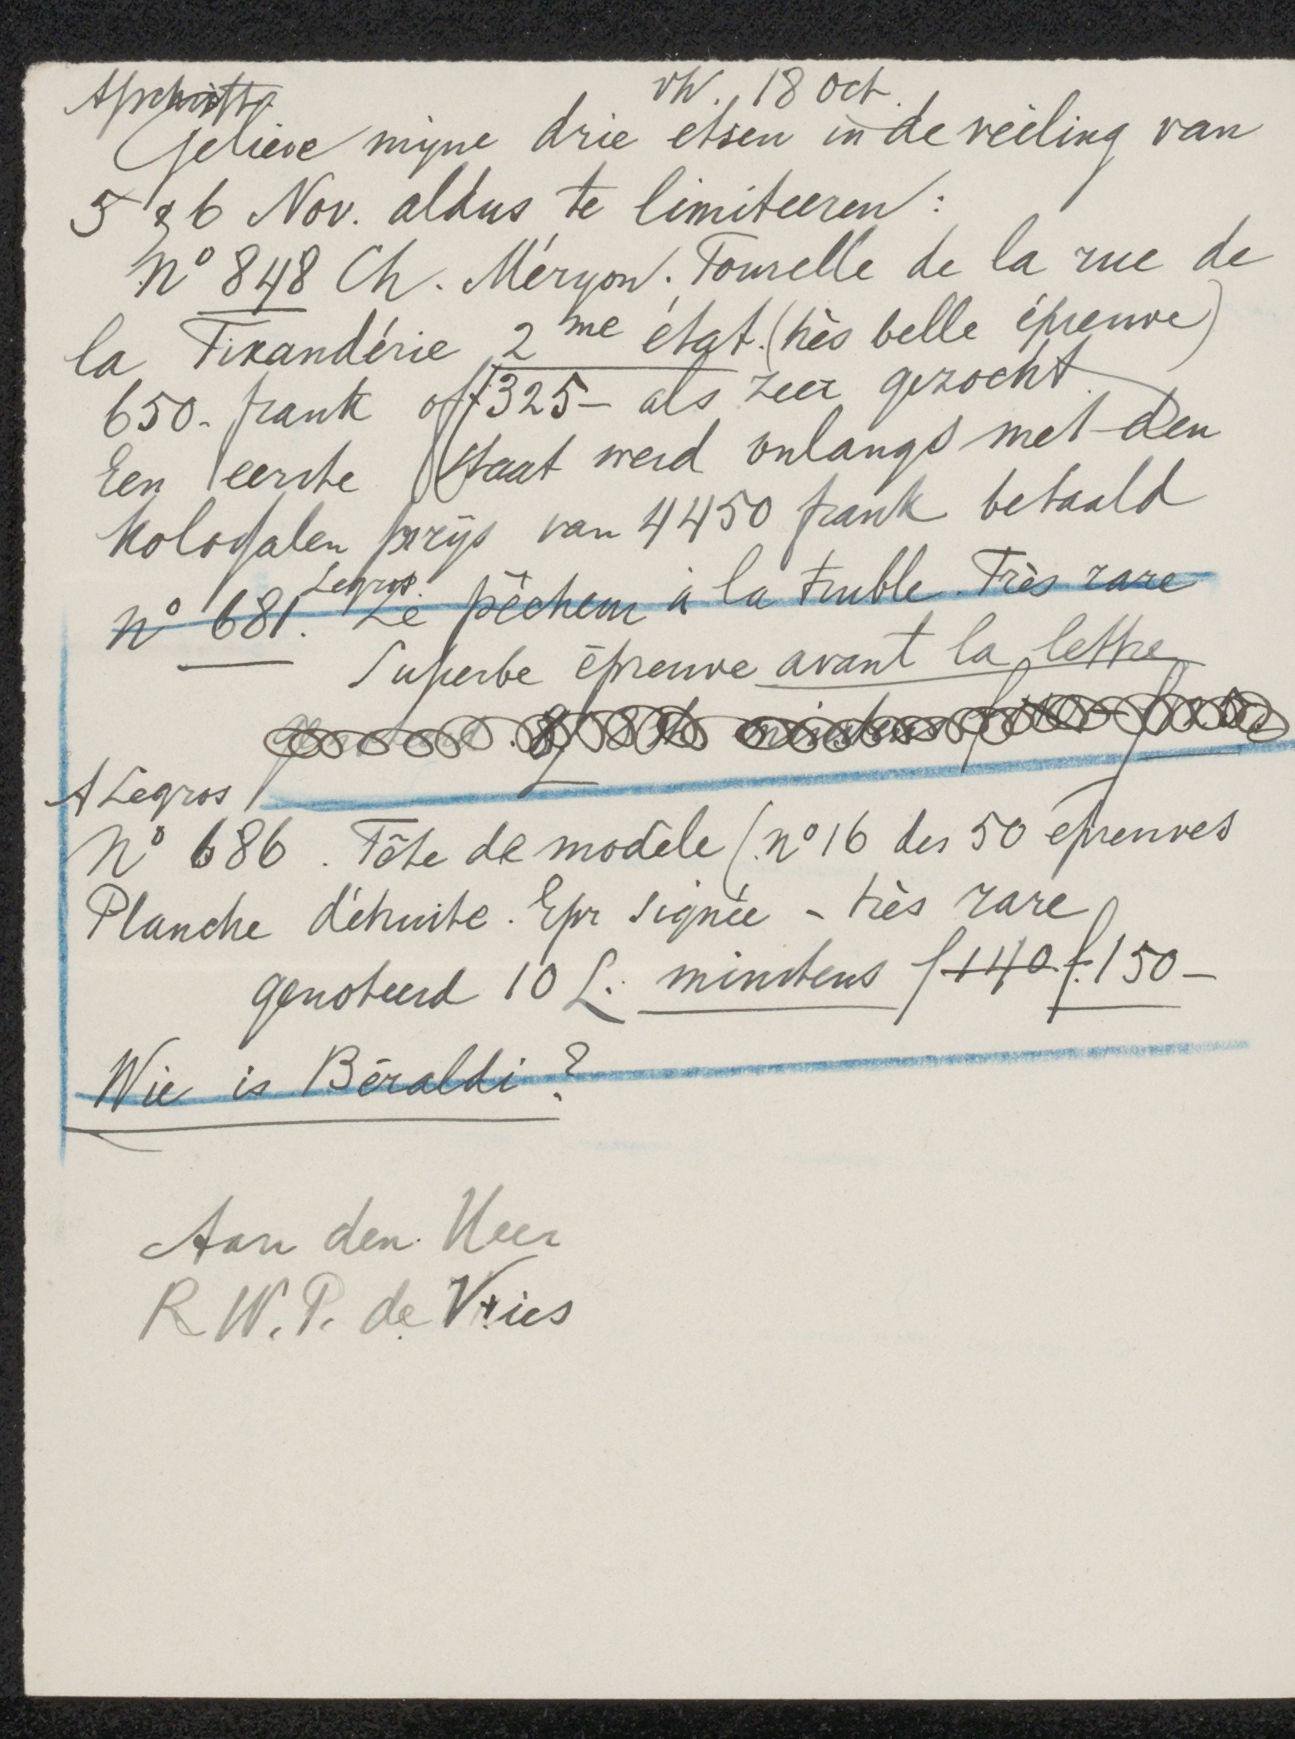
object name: letter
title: Brief aan Reinier Willem Petrus de Vries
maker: august allebé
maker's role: draughtsman, print maker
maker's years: 1838-1927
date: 1851-1919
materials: ink, paper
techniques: pen, writing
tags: amsterdam, auctioneer, publisher, reinier willem petrus de vries (1841-1919), paris, print maker, charles meryon, art trade, art shop, the graphic arts, money